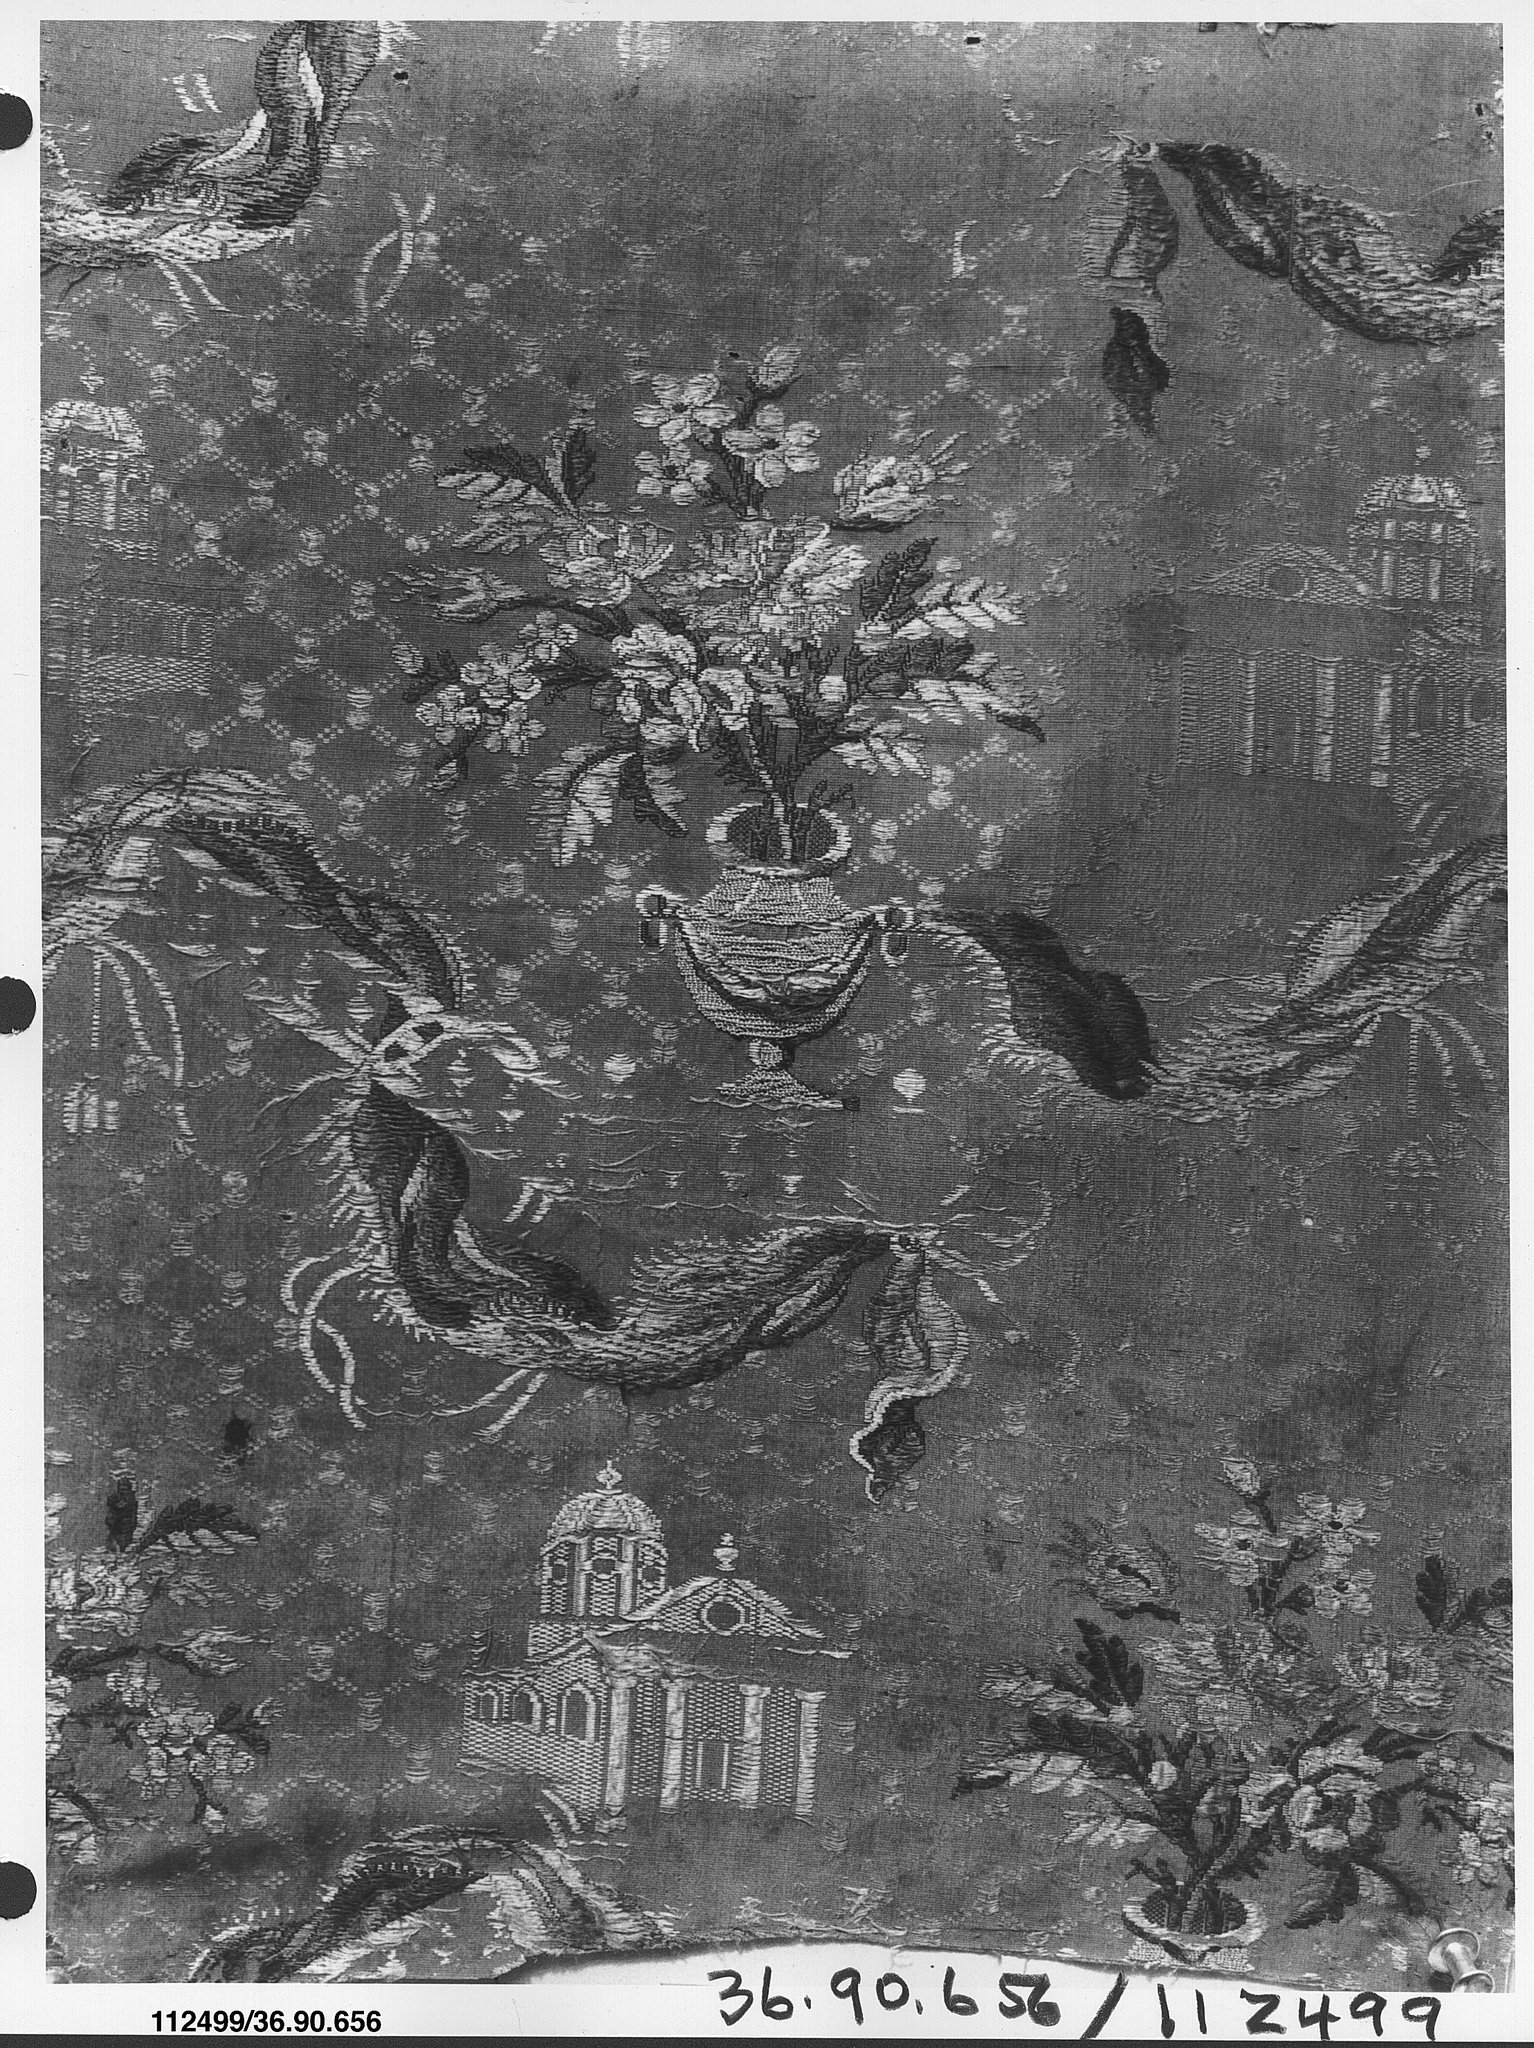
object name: piece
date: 1750-1760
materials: silk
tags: churches,flowers